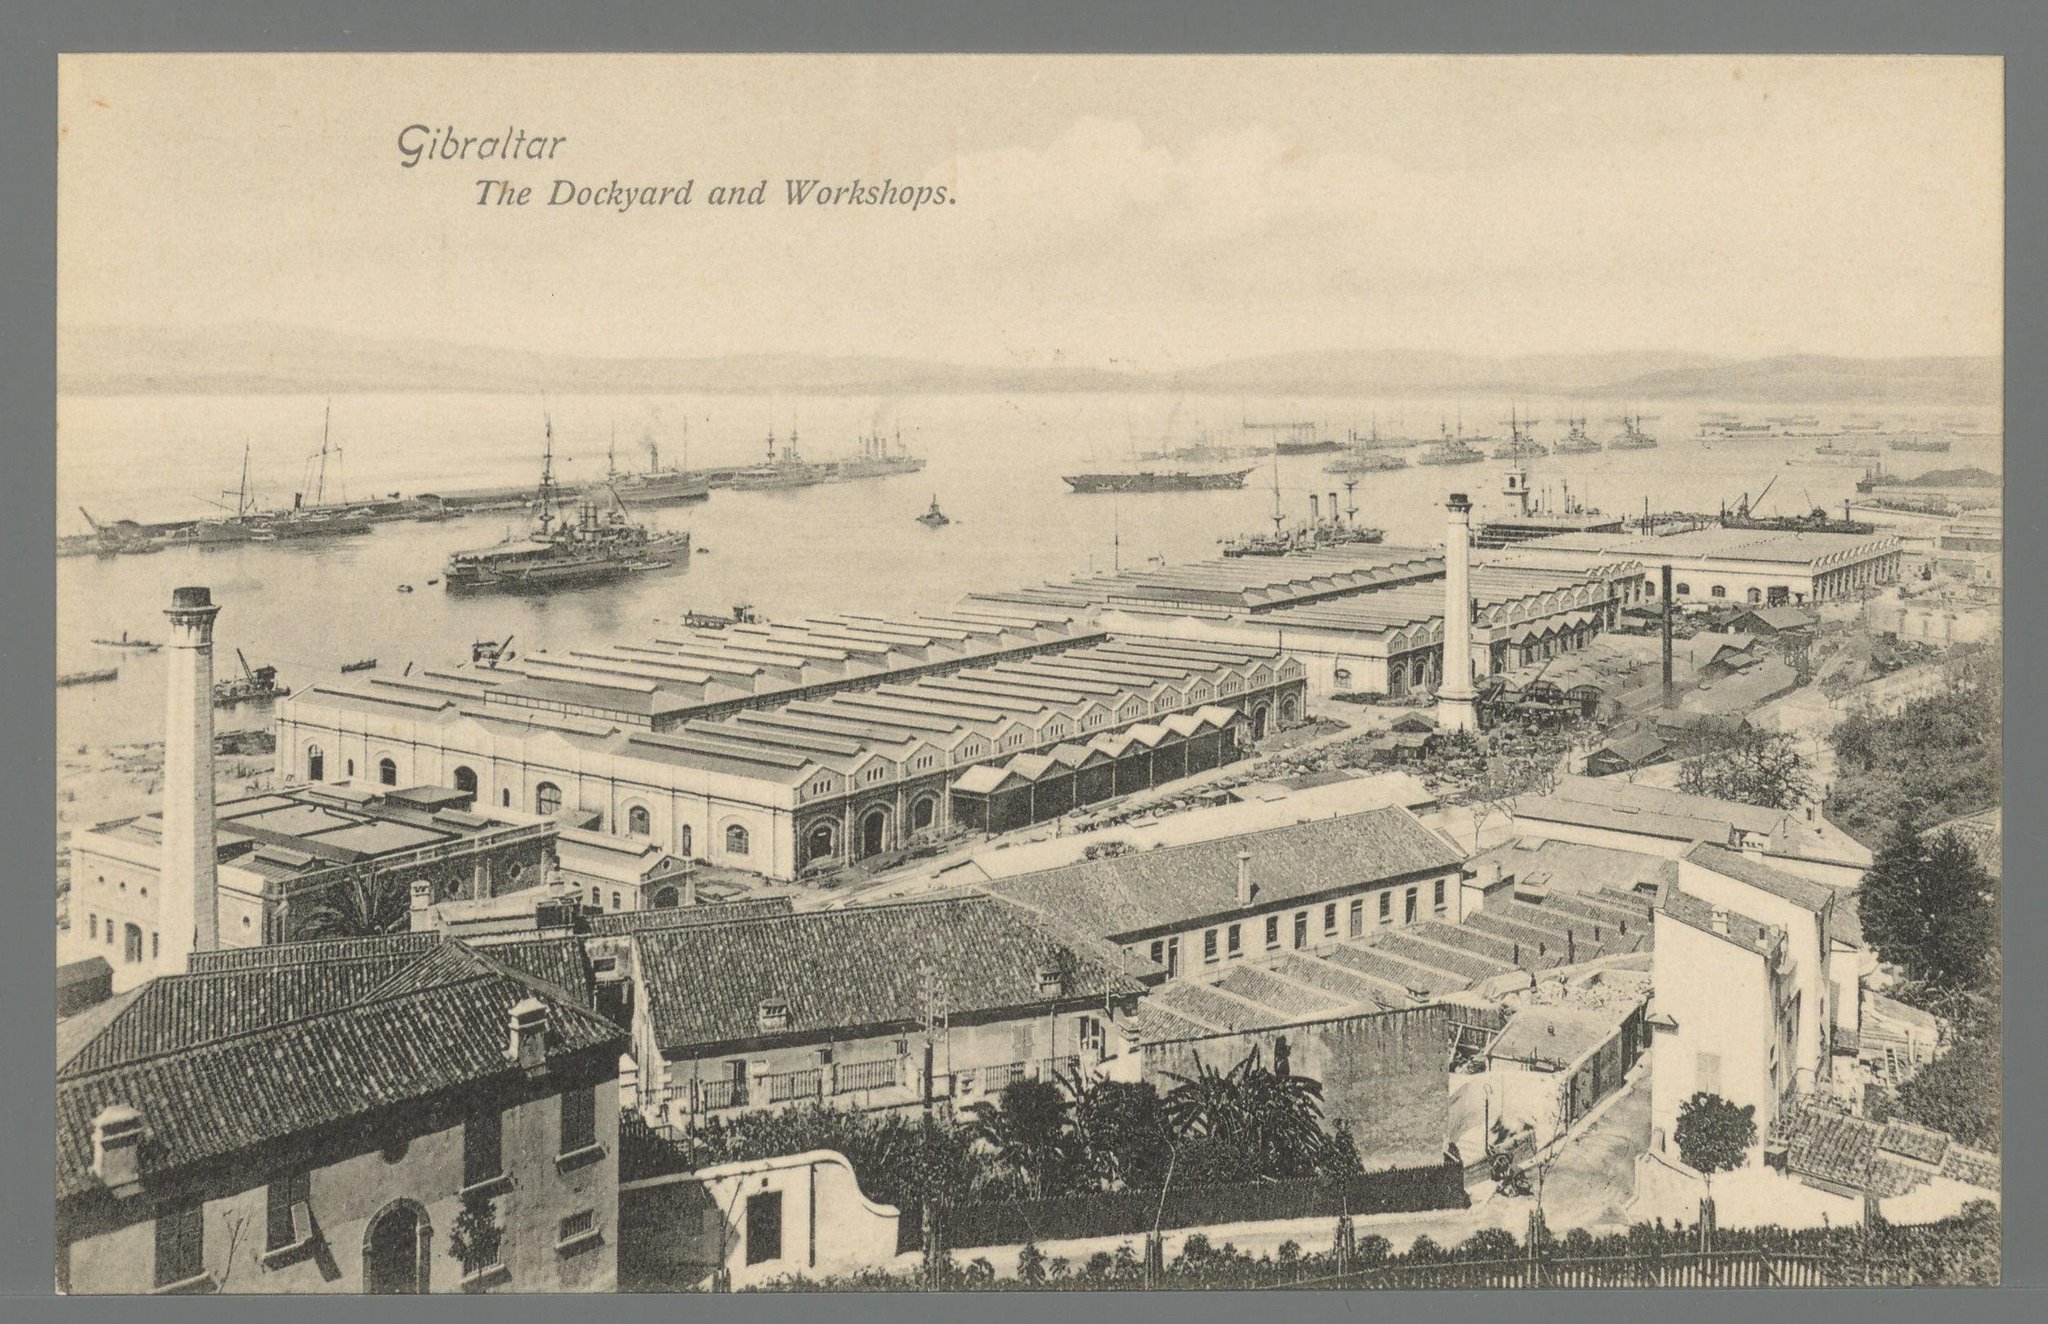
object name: ansichtkaart, prentbriefkaart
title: Gibraltar. The Dockyard and Workshops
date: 1906-1930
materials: cardboard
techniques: photograph, writing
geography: gibraltar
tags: workshop, shipyard, shipdock